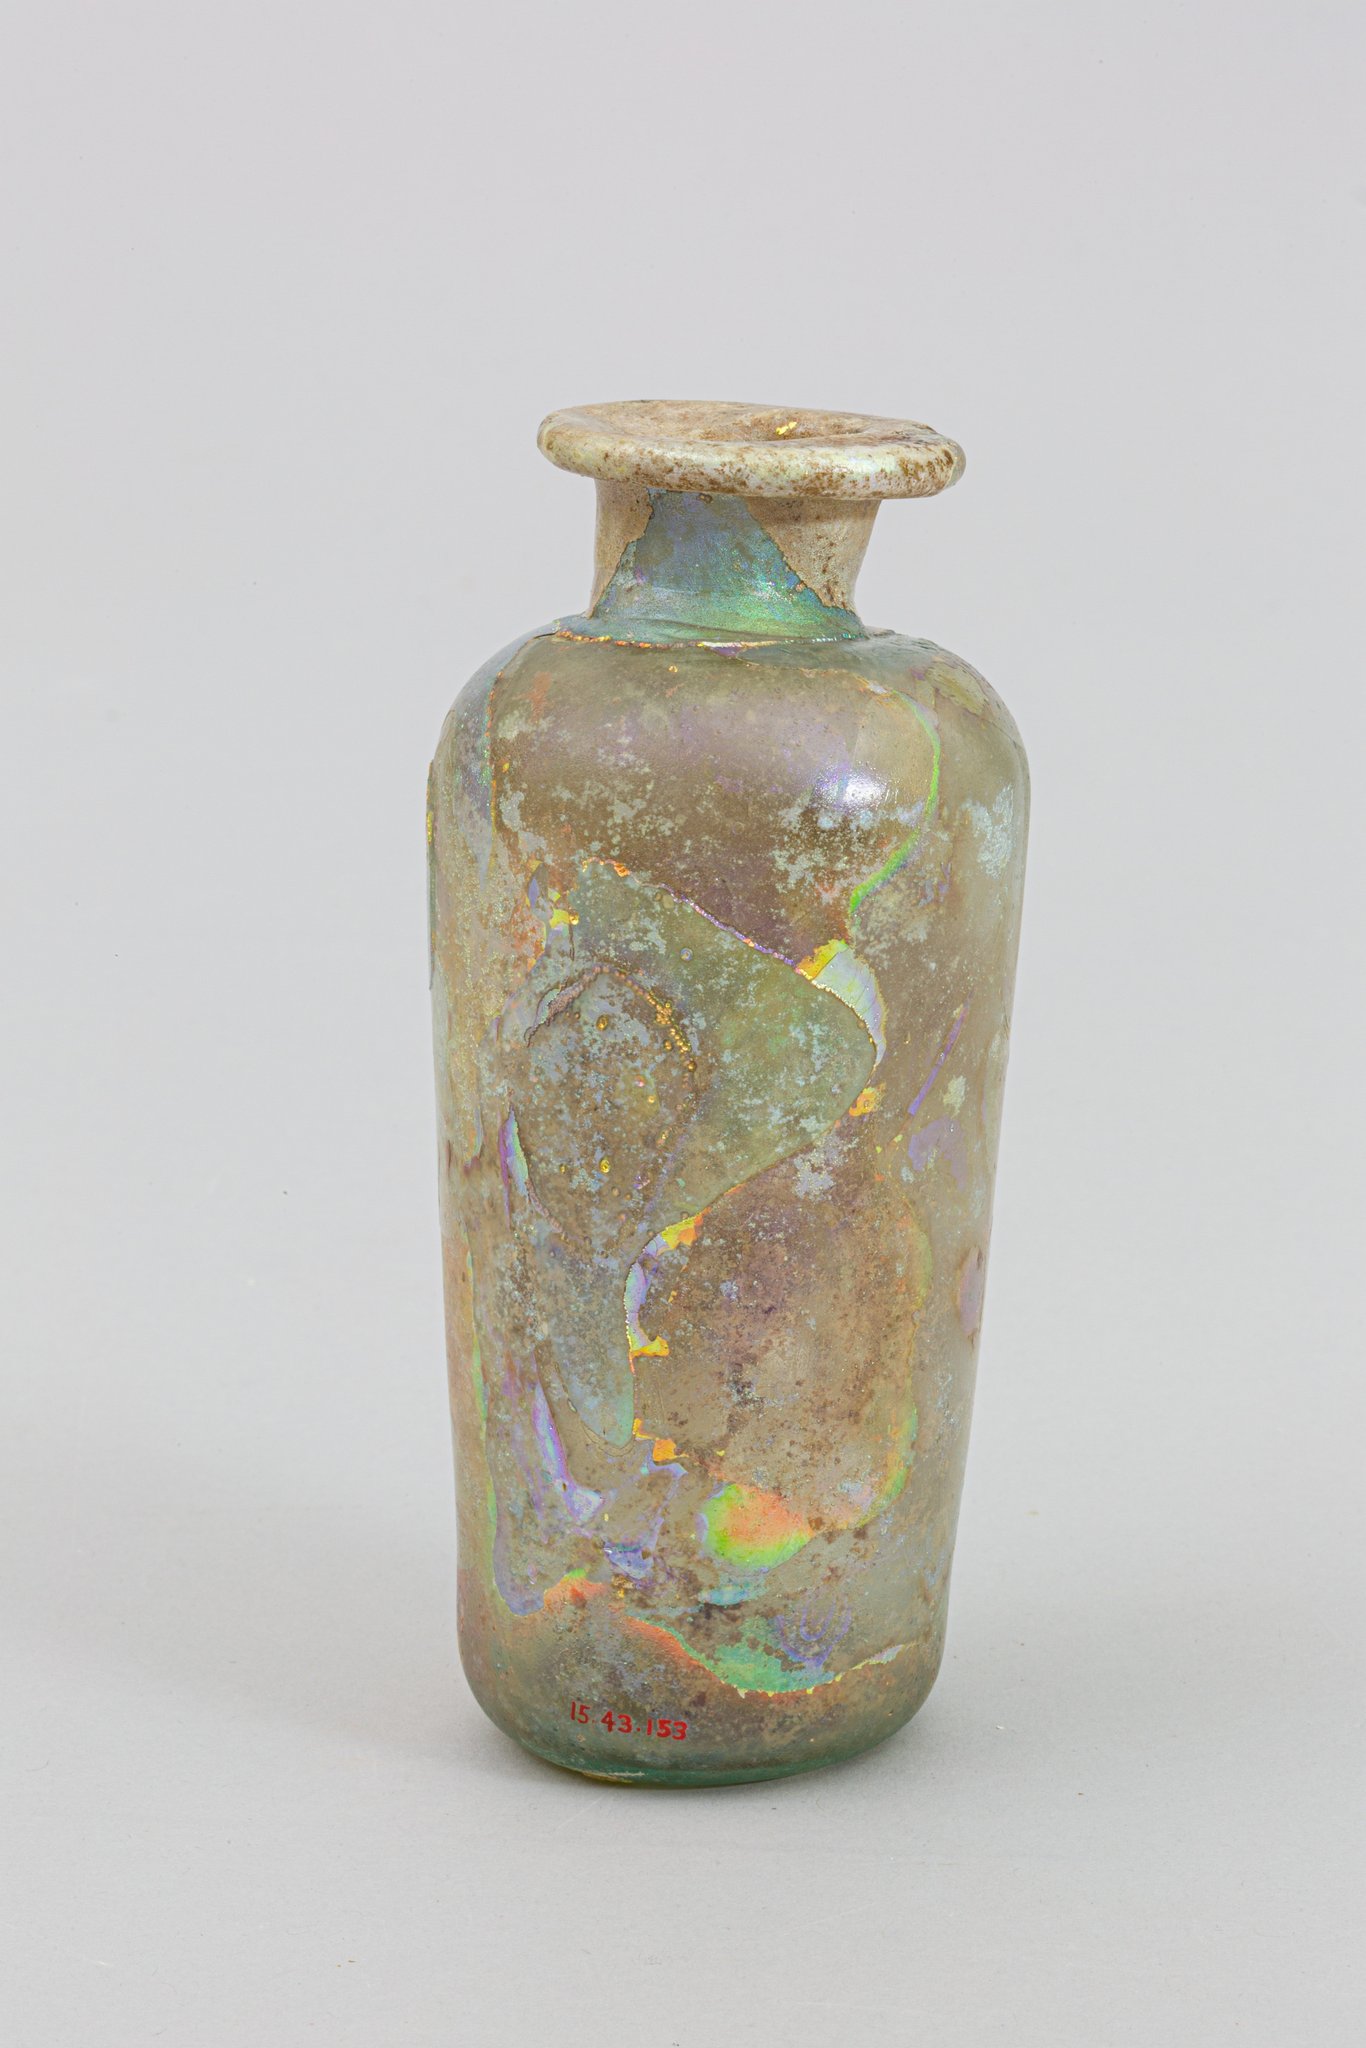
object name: bottle, cylindrical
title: Glass cylindrical bottle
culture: roman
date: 67-200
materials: glass